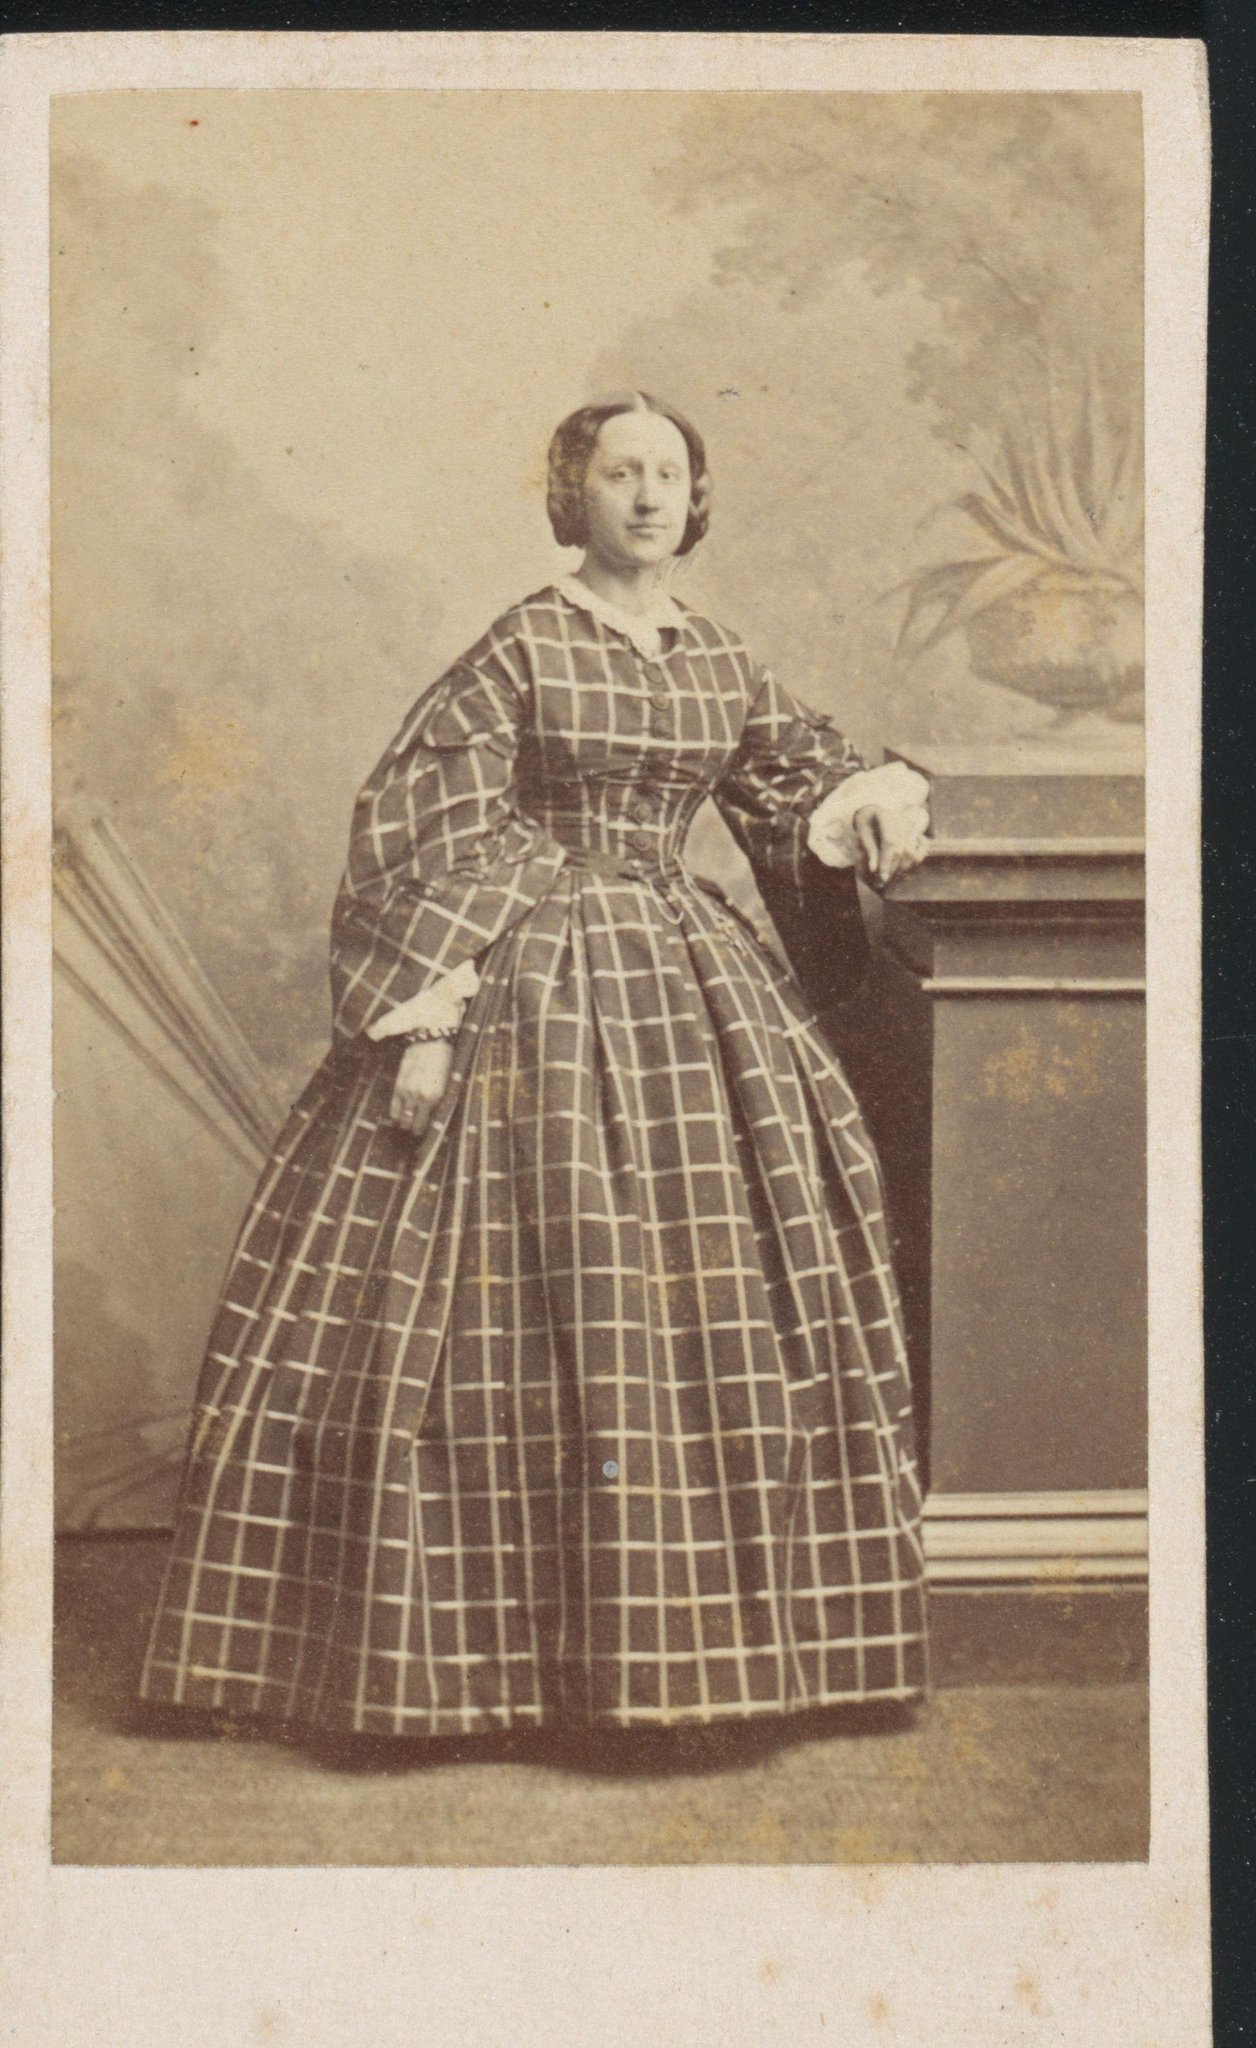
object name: photograph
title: Portret van een jonge vrouw in een lange geruite jurk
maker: matthijs adolph conen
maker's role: painter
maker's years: 1833-1894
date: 1861-1867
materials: cardboard, photographic support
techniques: albumen print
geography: amsterdam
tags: dress, gown, amsterdam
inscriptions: address: ‘Amsterdam Plantage Middenlaan 132’